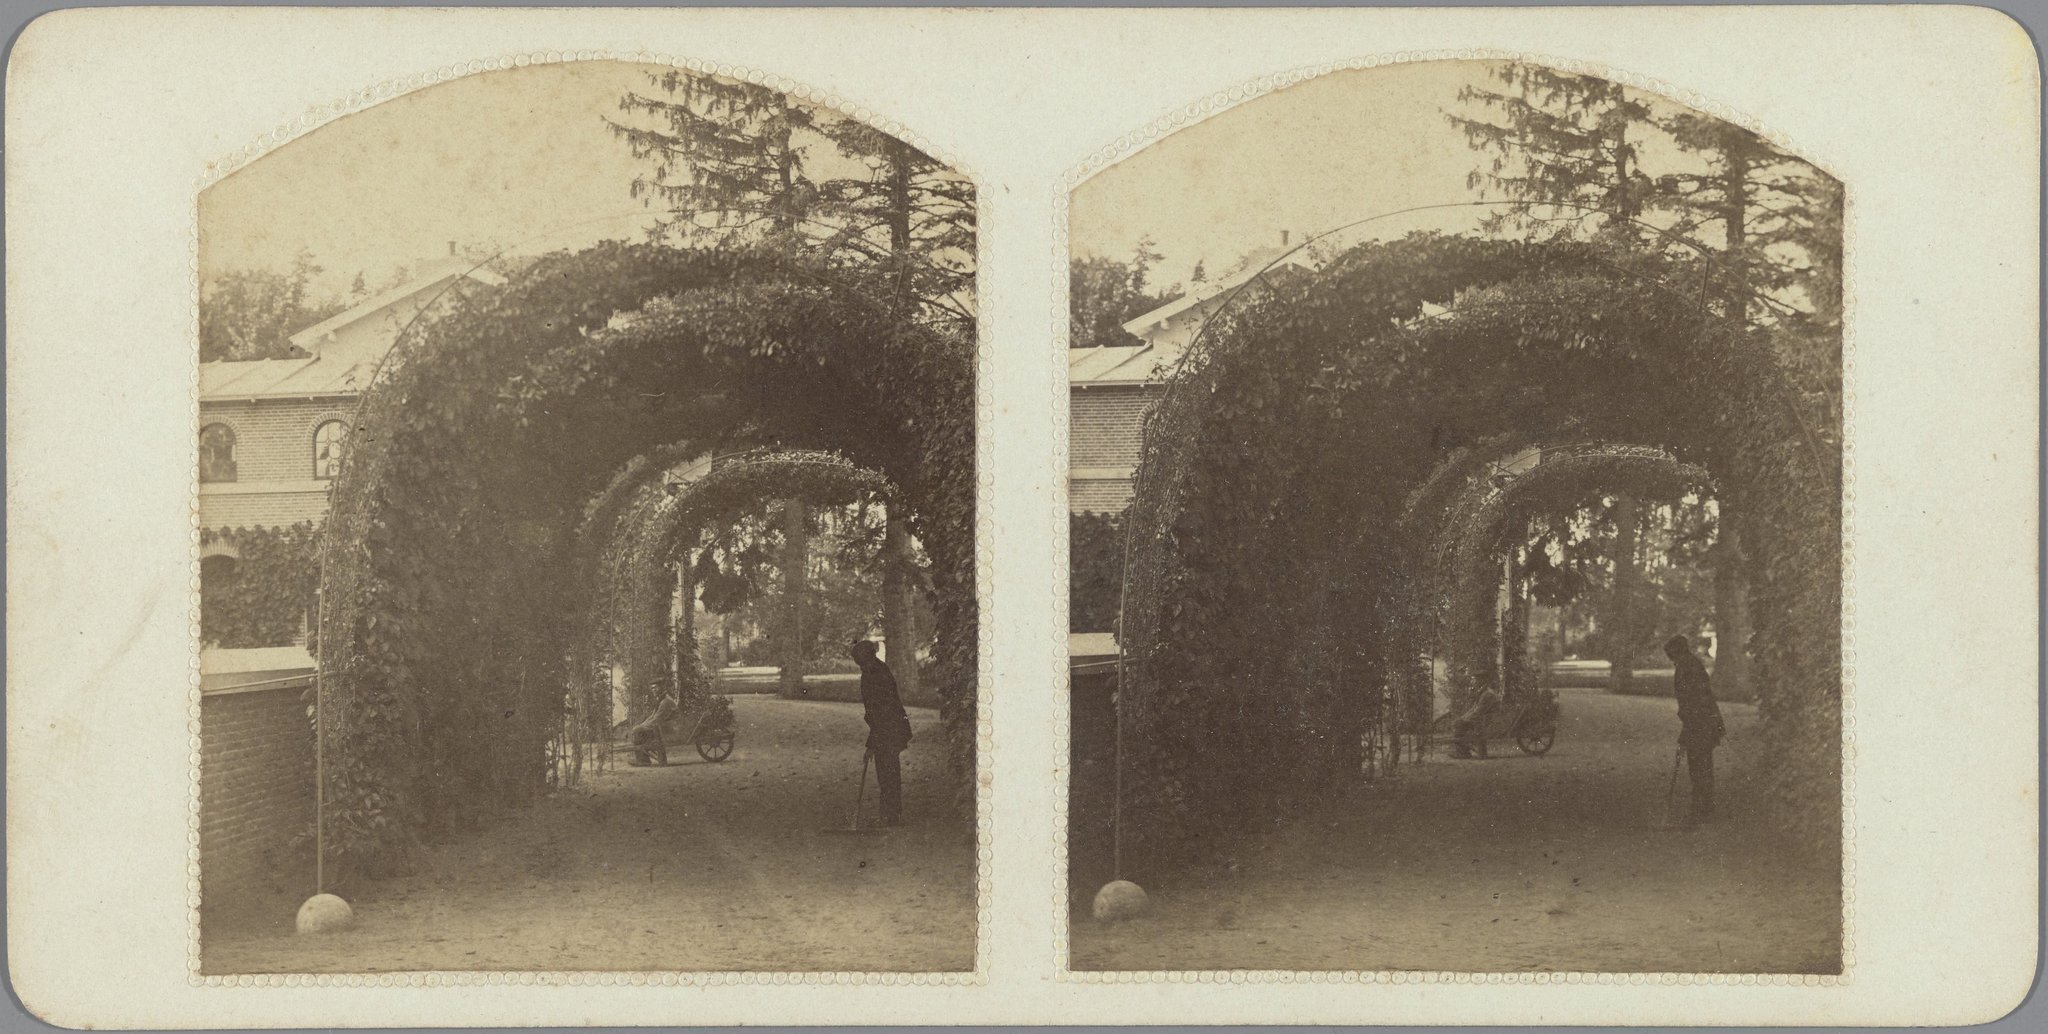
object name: stereograph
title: Mannen in een loofgang (berceau)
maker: Anonymous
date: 1860-1880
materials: cardboard, paper, photographic support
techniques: albumen print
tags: garden